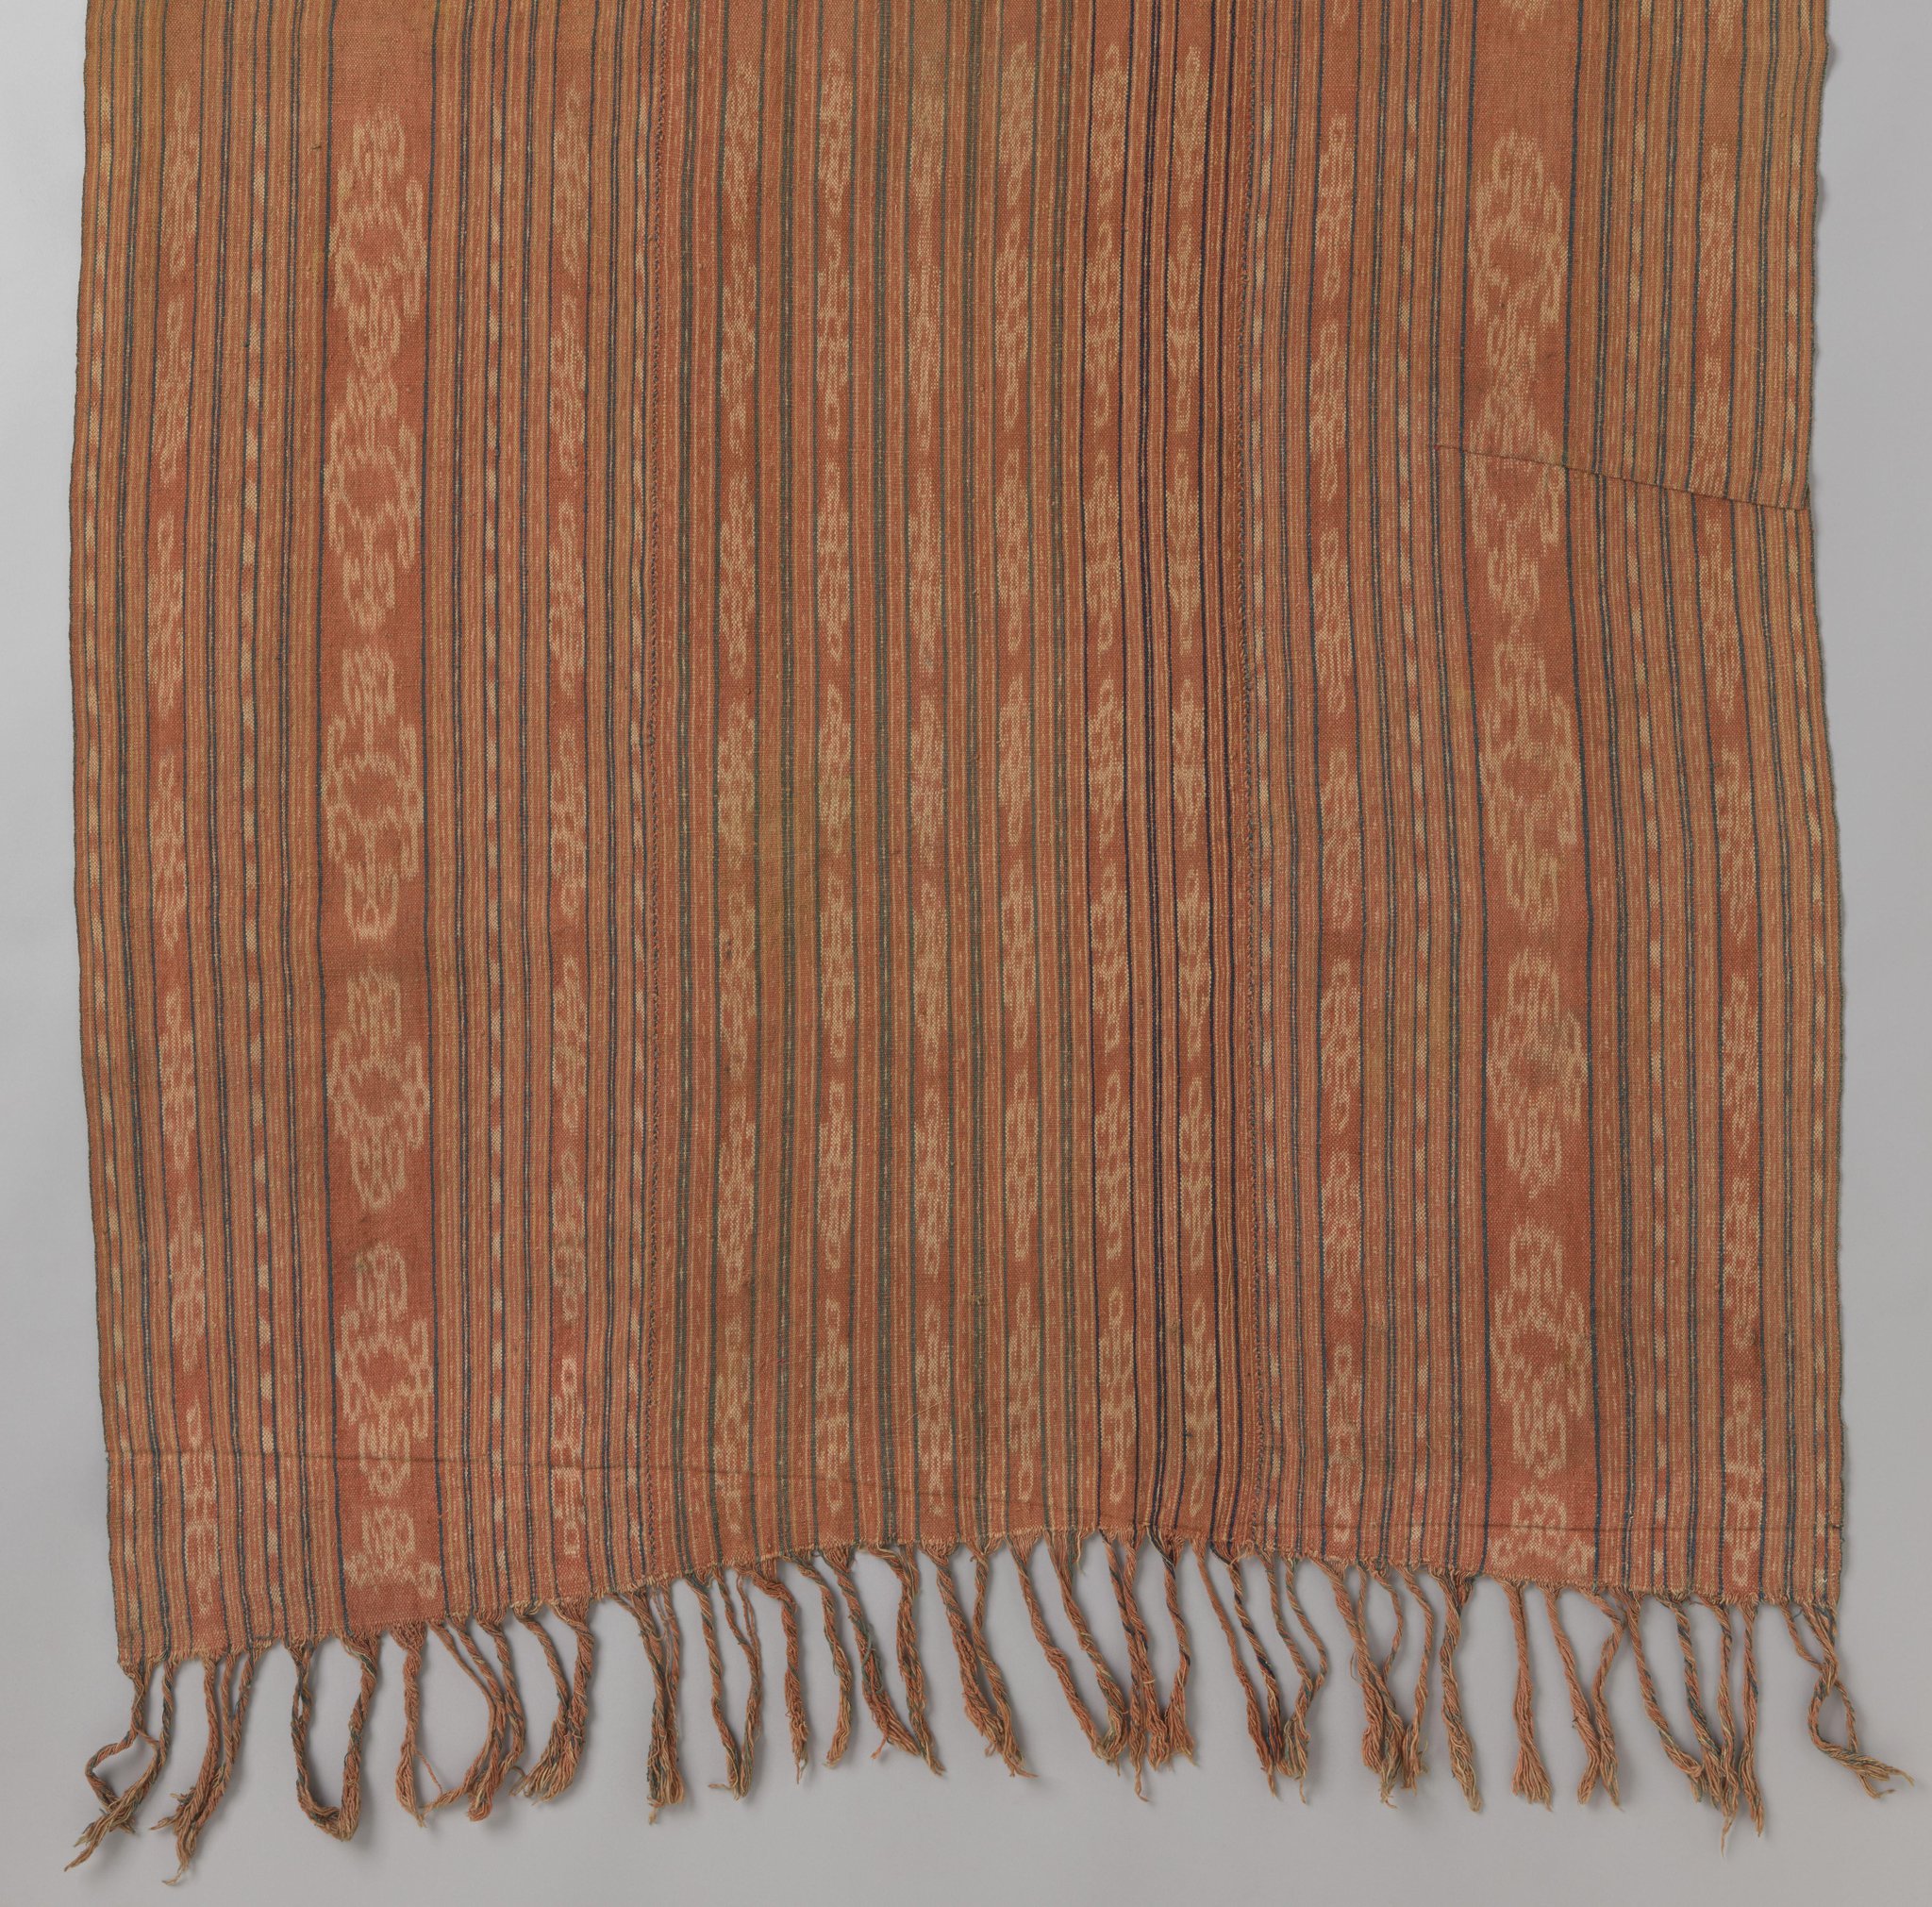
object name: kleed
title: Kleed, ikat weefsel, afkomstig uit Soemba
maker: Anonymous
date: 1937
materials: cotton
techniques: ikat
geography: indonesia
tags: indonesia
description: Kleed van oosterse textiel; ikat weefsel. Het kleed bestaat uit drie aan elkaar genaaide banen. Het patroon heeft banen in roodbruin, blauw en crème. Langs de boven- en onderzijde loopt franje van de kettingdraden.